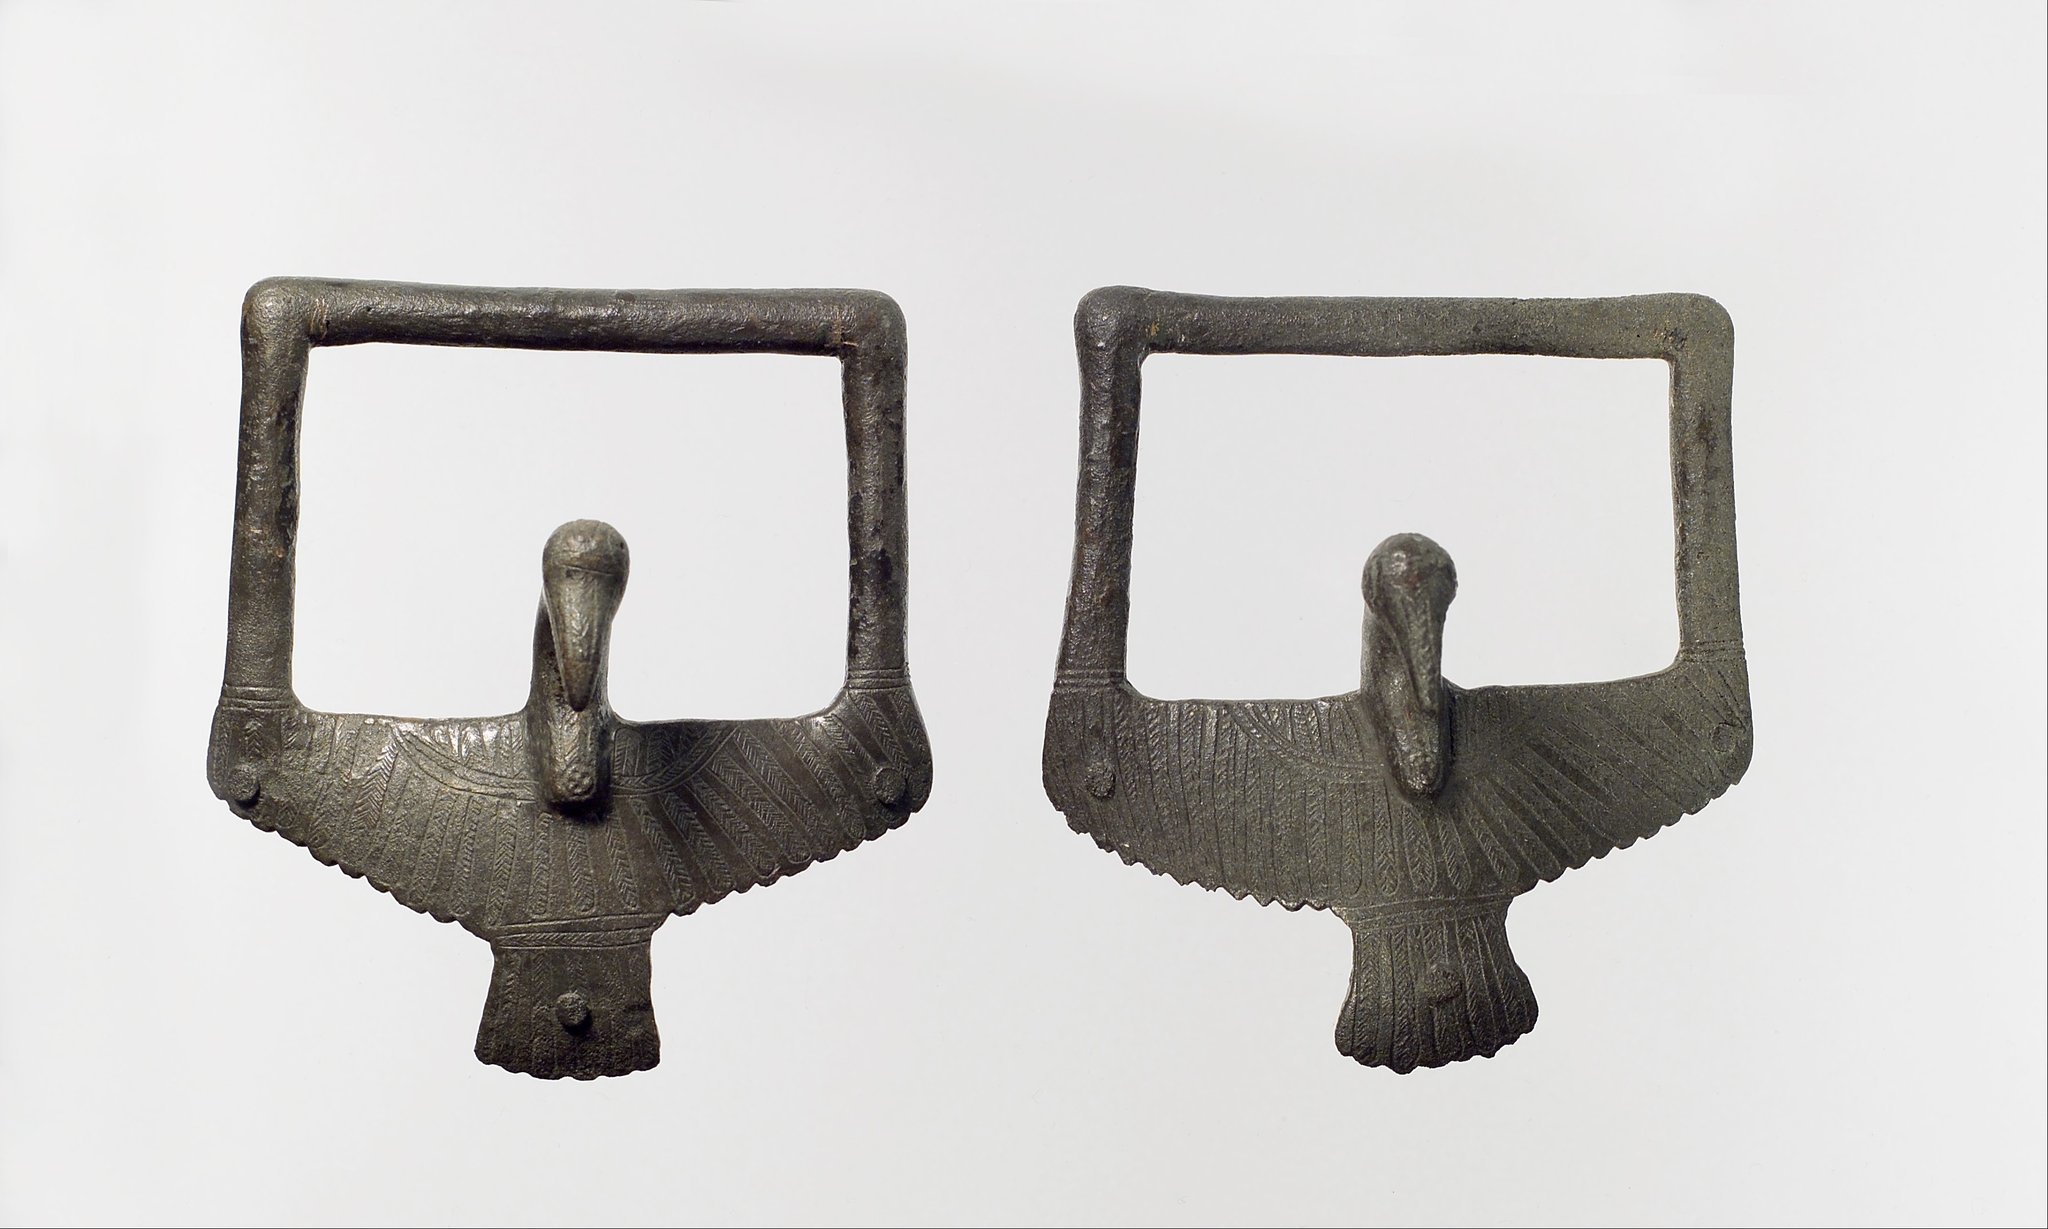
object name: handle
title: Pair of bird-shaped handles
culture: iranian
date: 900-801 BCE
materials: bronze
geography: iran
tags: birds